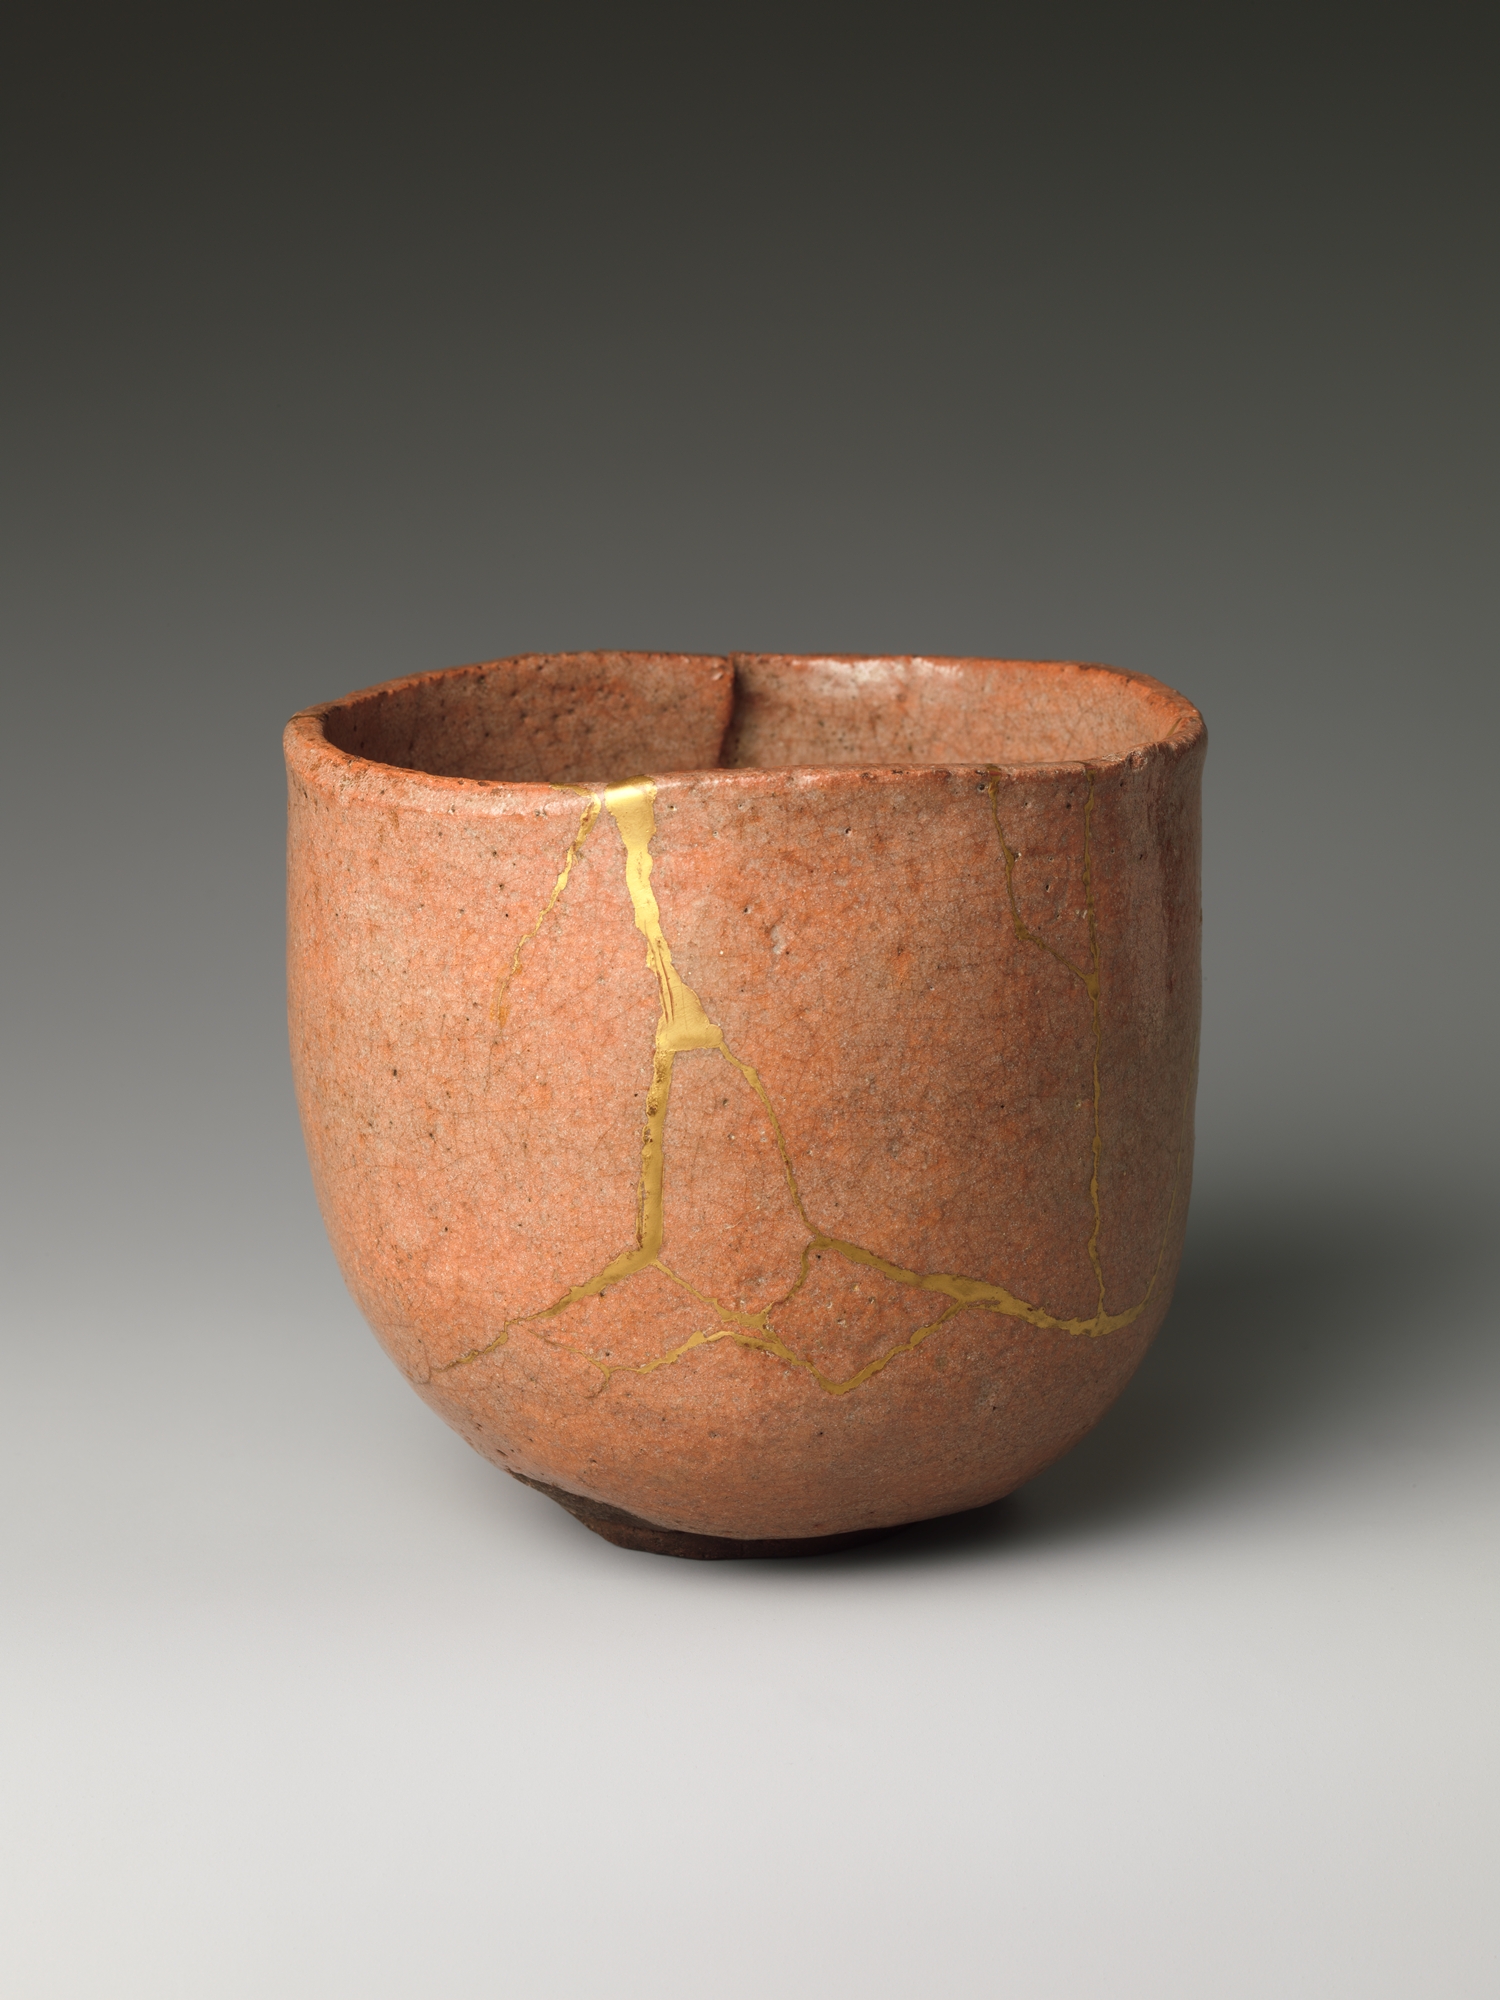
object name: teabowl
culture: japanese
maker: hon'ami kōetsu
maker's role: artist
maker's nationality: japanese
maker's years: 1558-1637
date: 1600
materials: clay, glaze